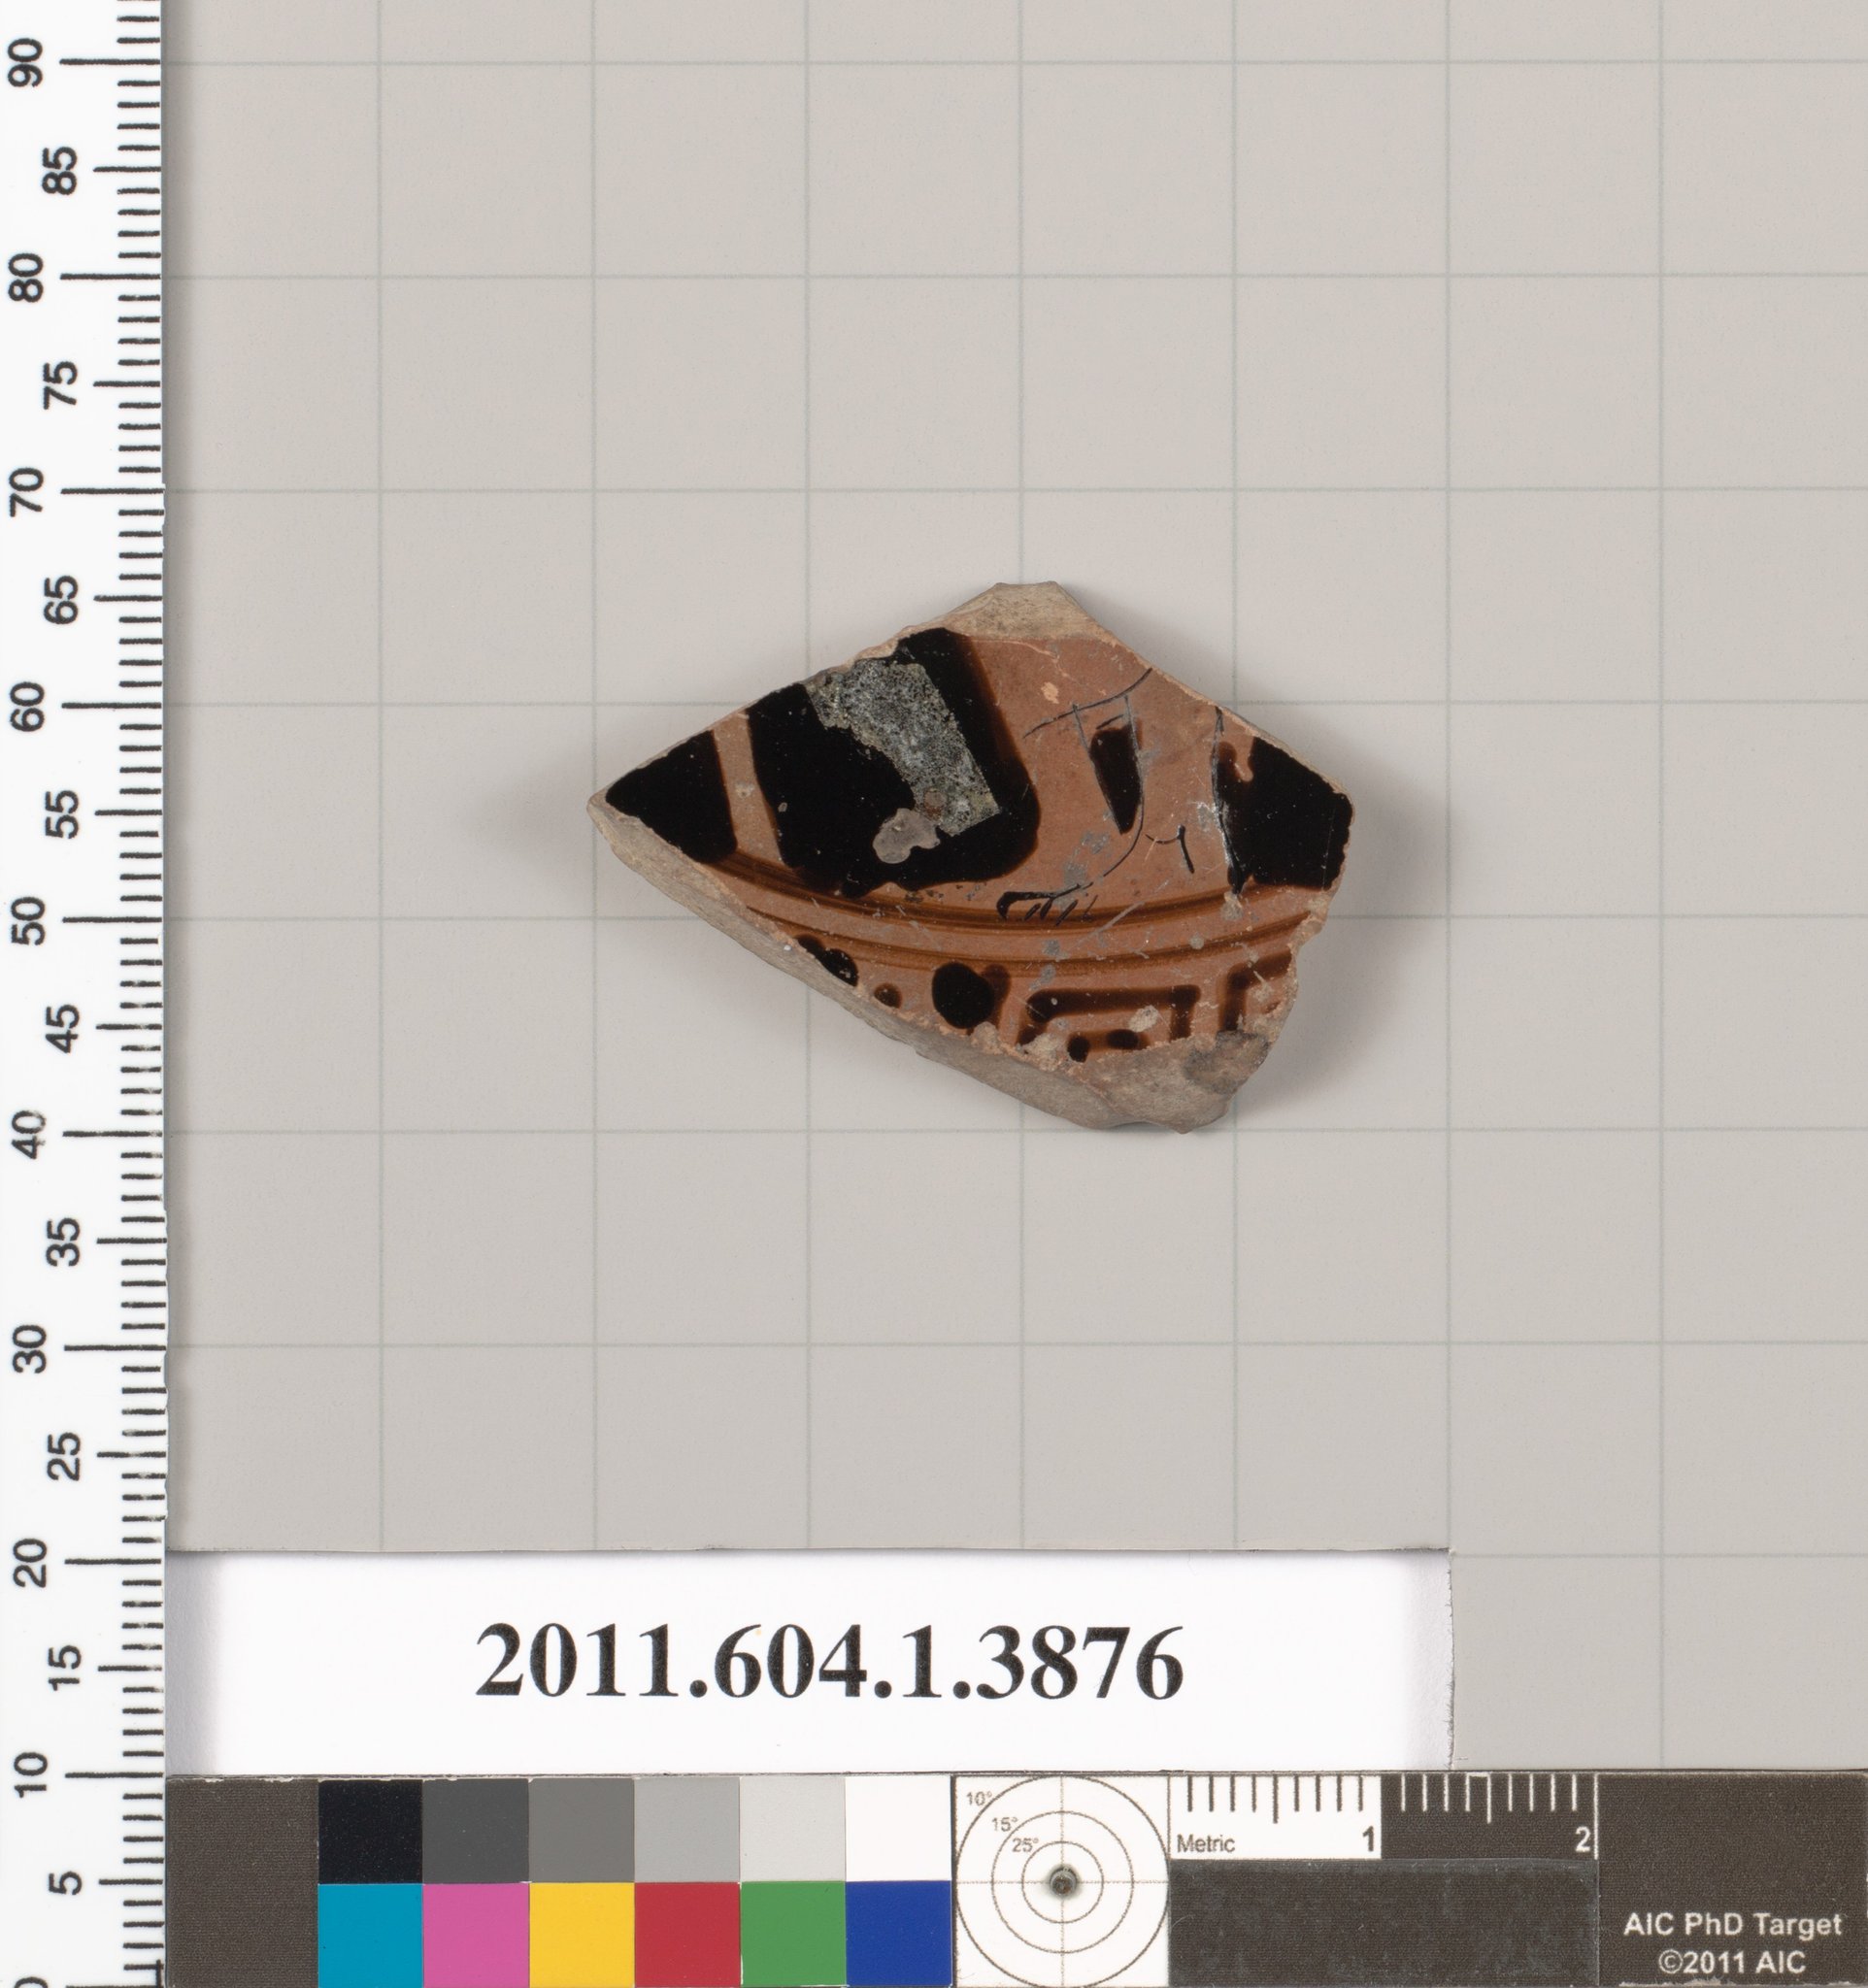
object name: kylix fragment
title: Terracotta fragment of a kylix (drinking cup)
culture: greek, attic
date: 460-450 BCE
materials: terracotta